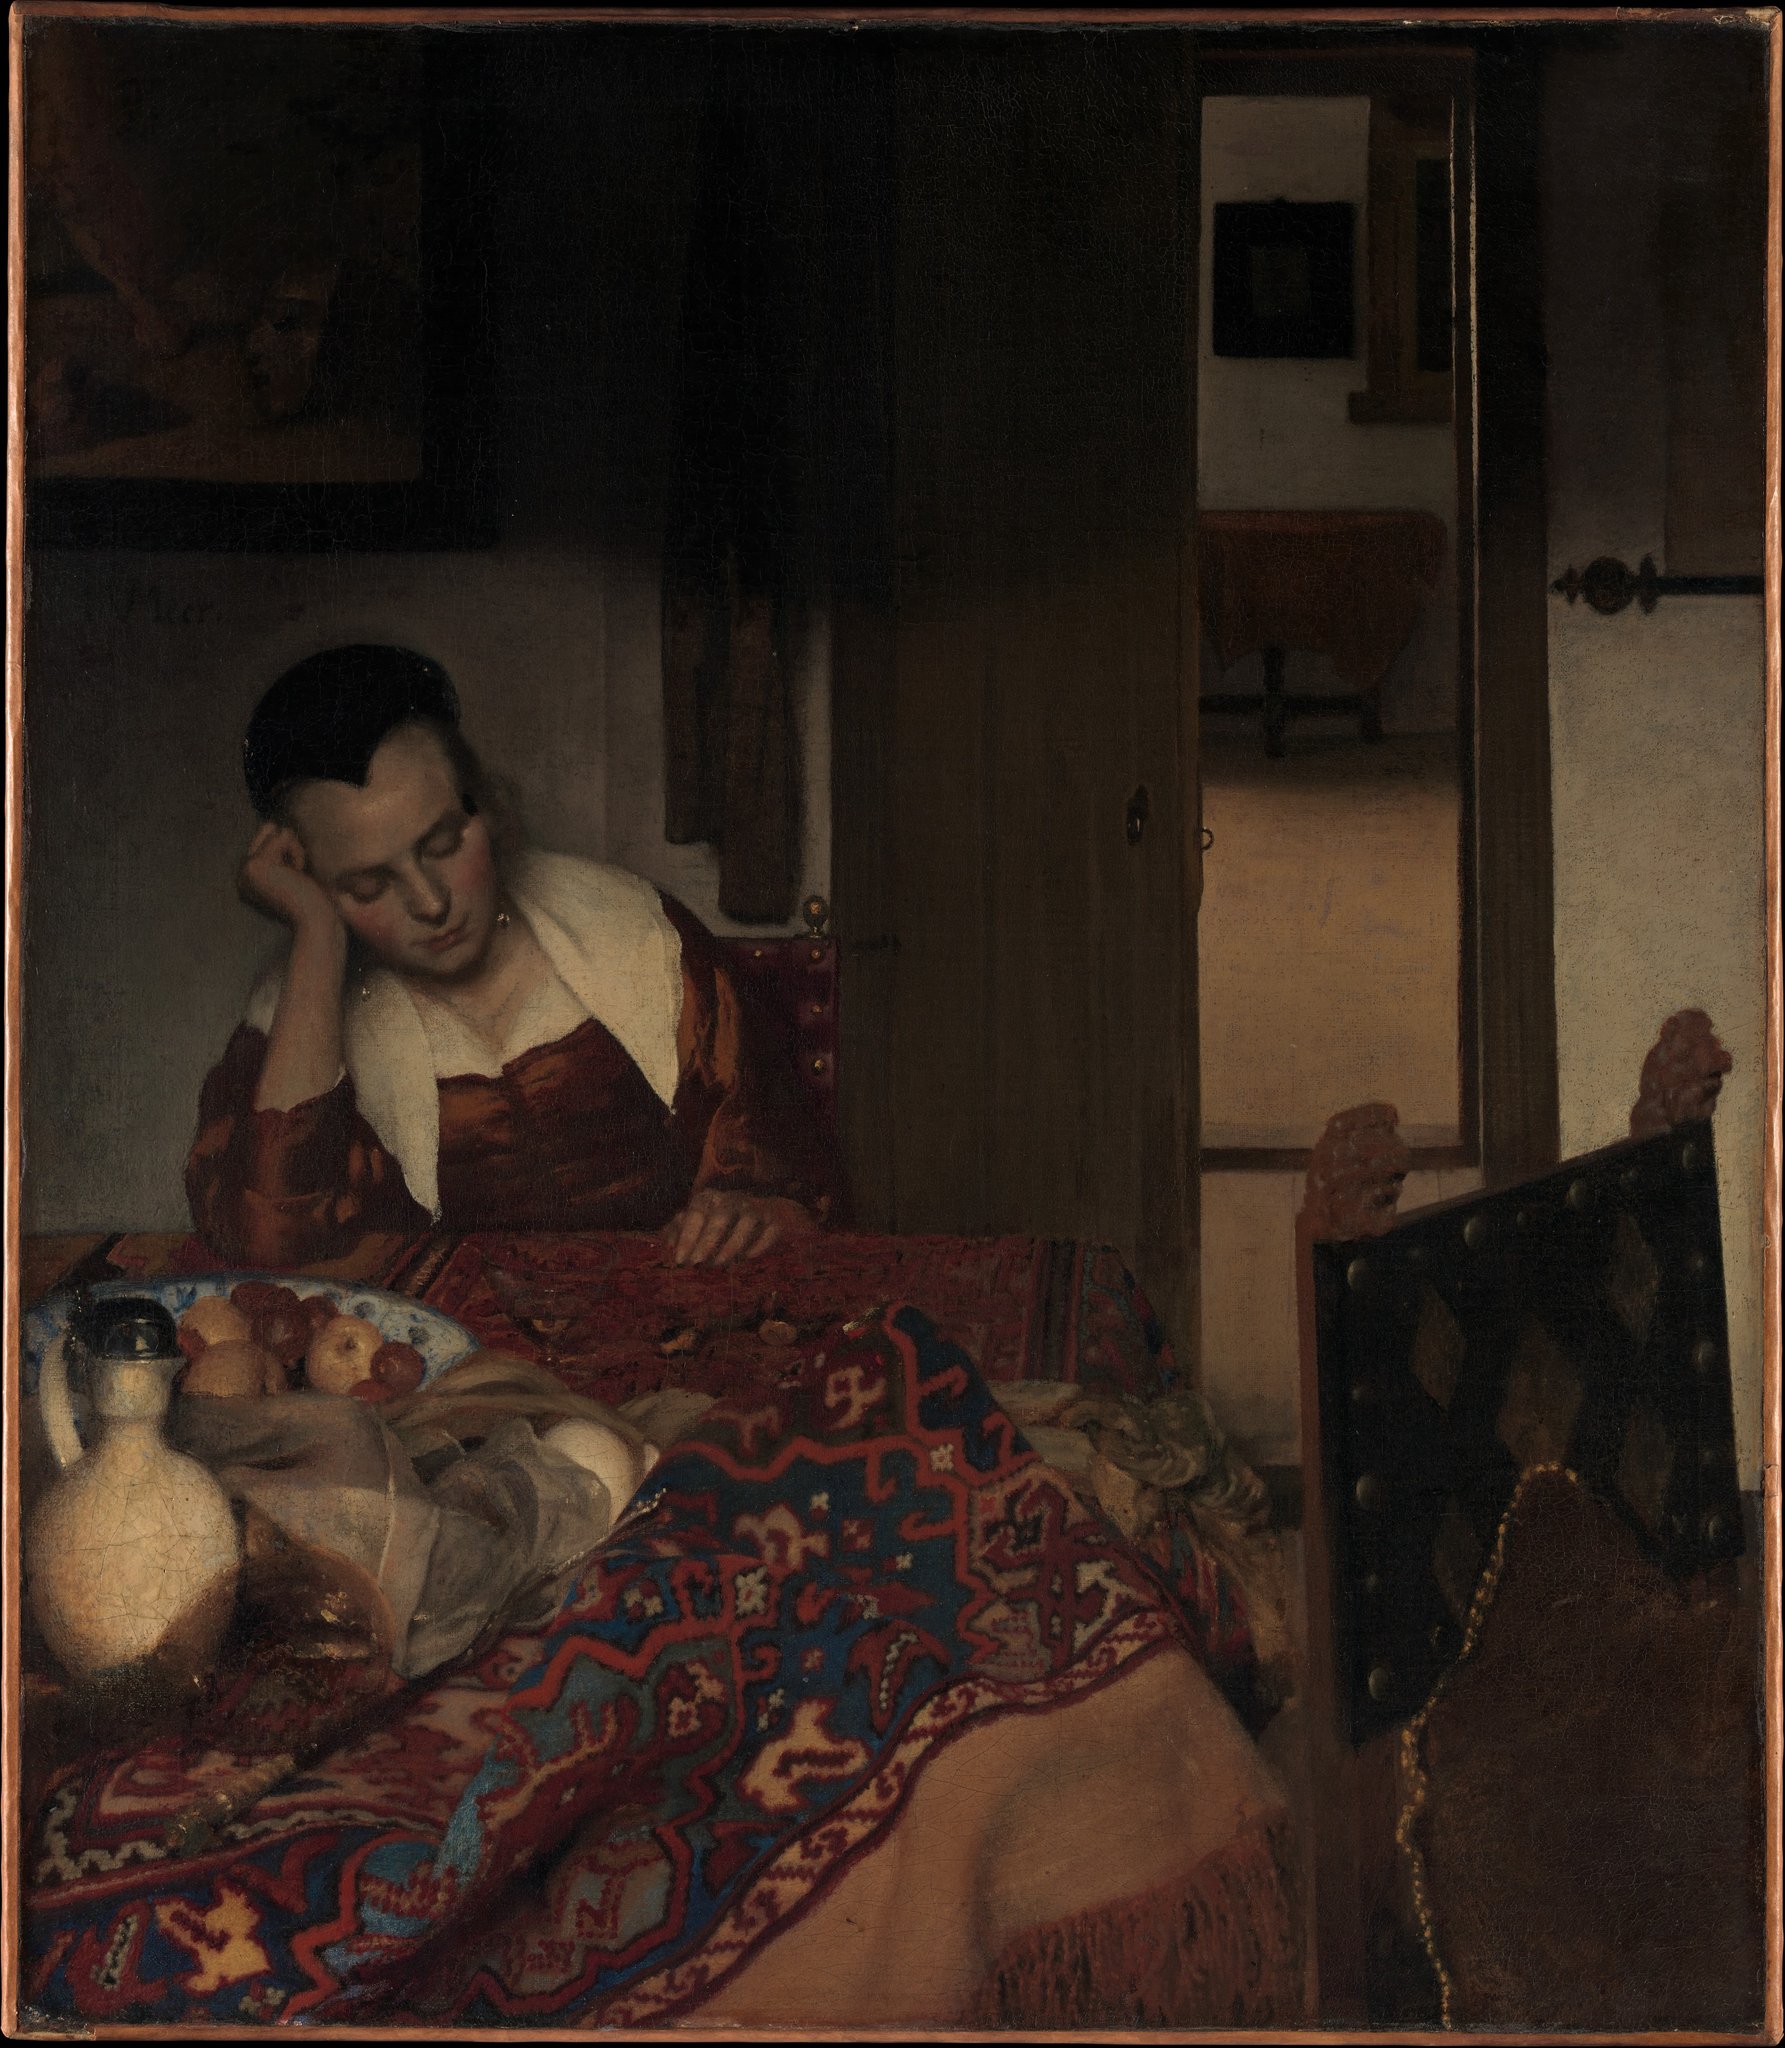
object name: painting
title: A Maid Asleep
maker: johannes vermeer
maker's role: artist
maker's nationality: dutch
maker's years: 1632-1675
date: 1656-1657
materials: canvas, oil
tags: interiors,fruit,sleeping,women,servants